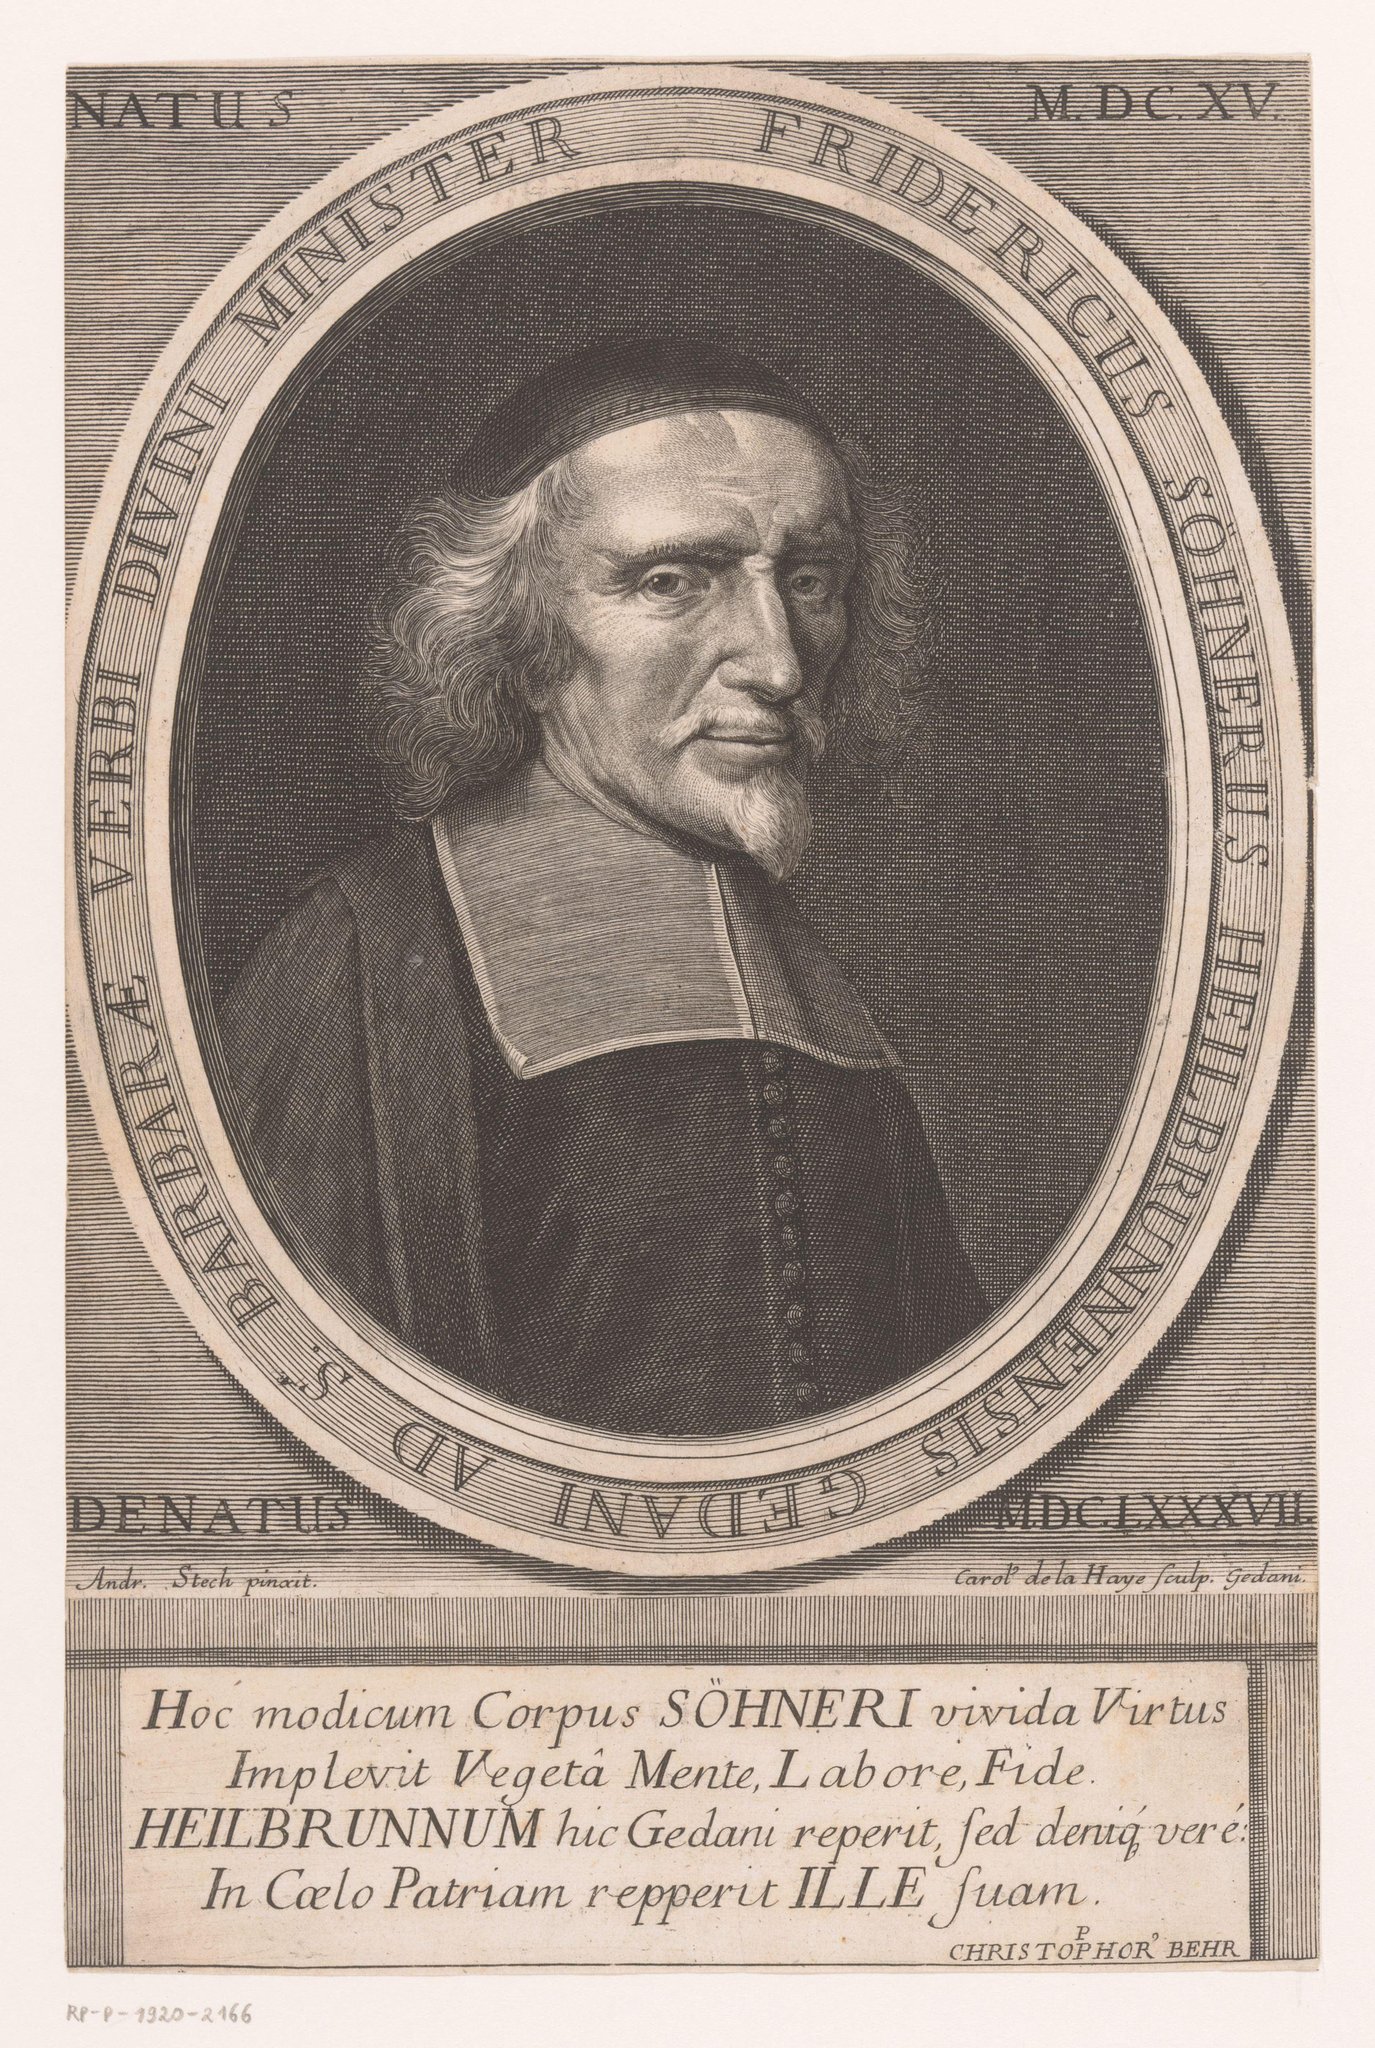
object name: print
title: Portret van Friedrich Söhner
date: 1687-1707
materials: paper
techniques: engraving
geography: danzig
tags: ornament ~ medallion, historical persons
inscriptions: collector's mark: Lugt 2228